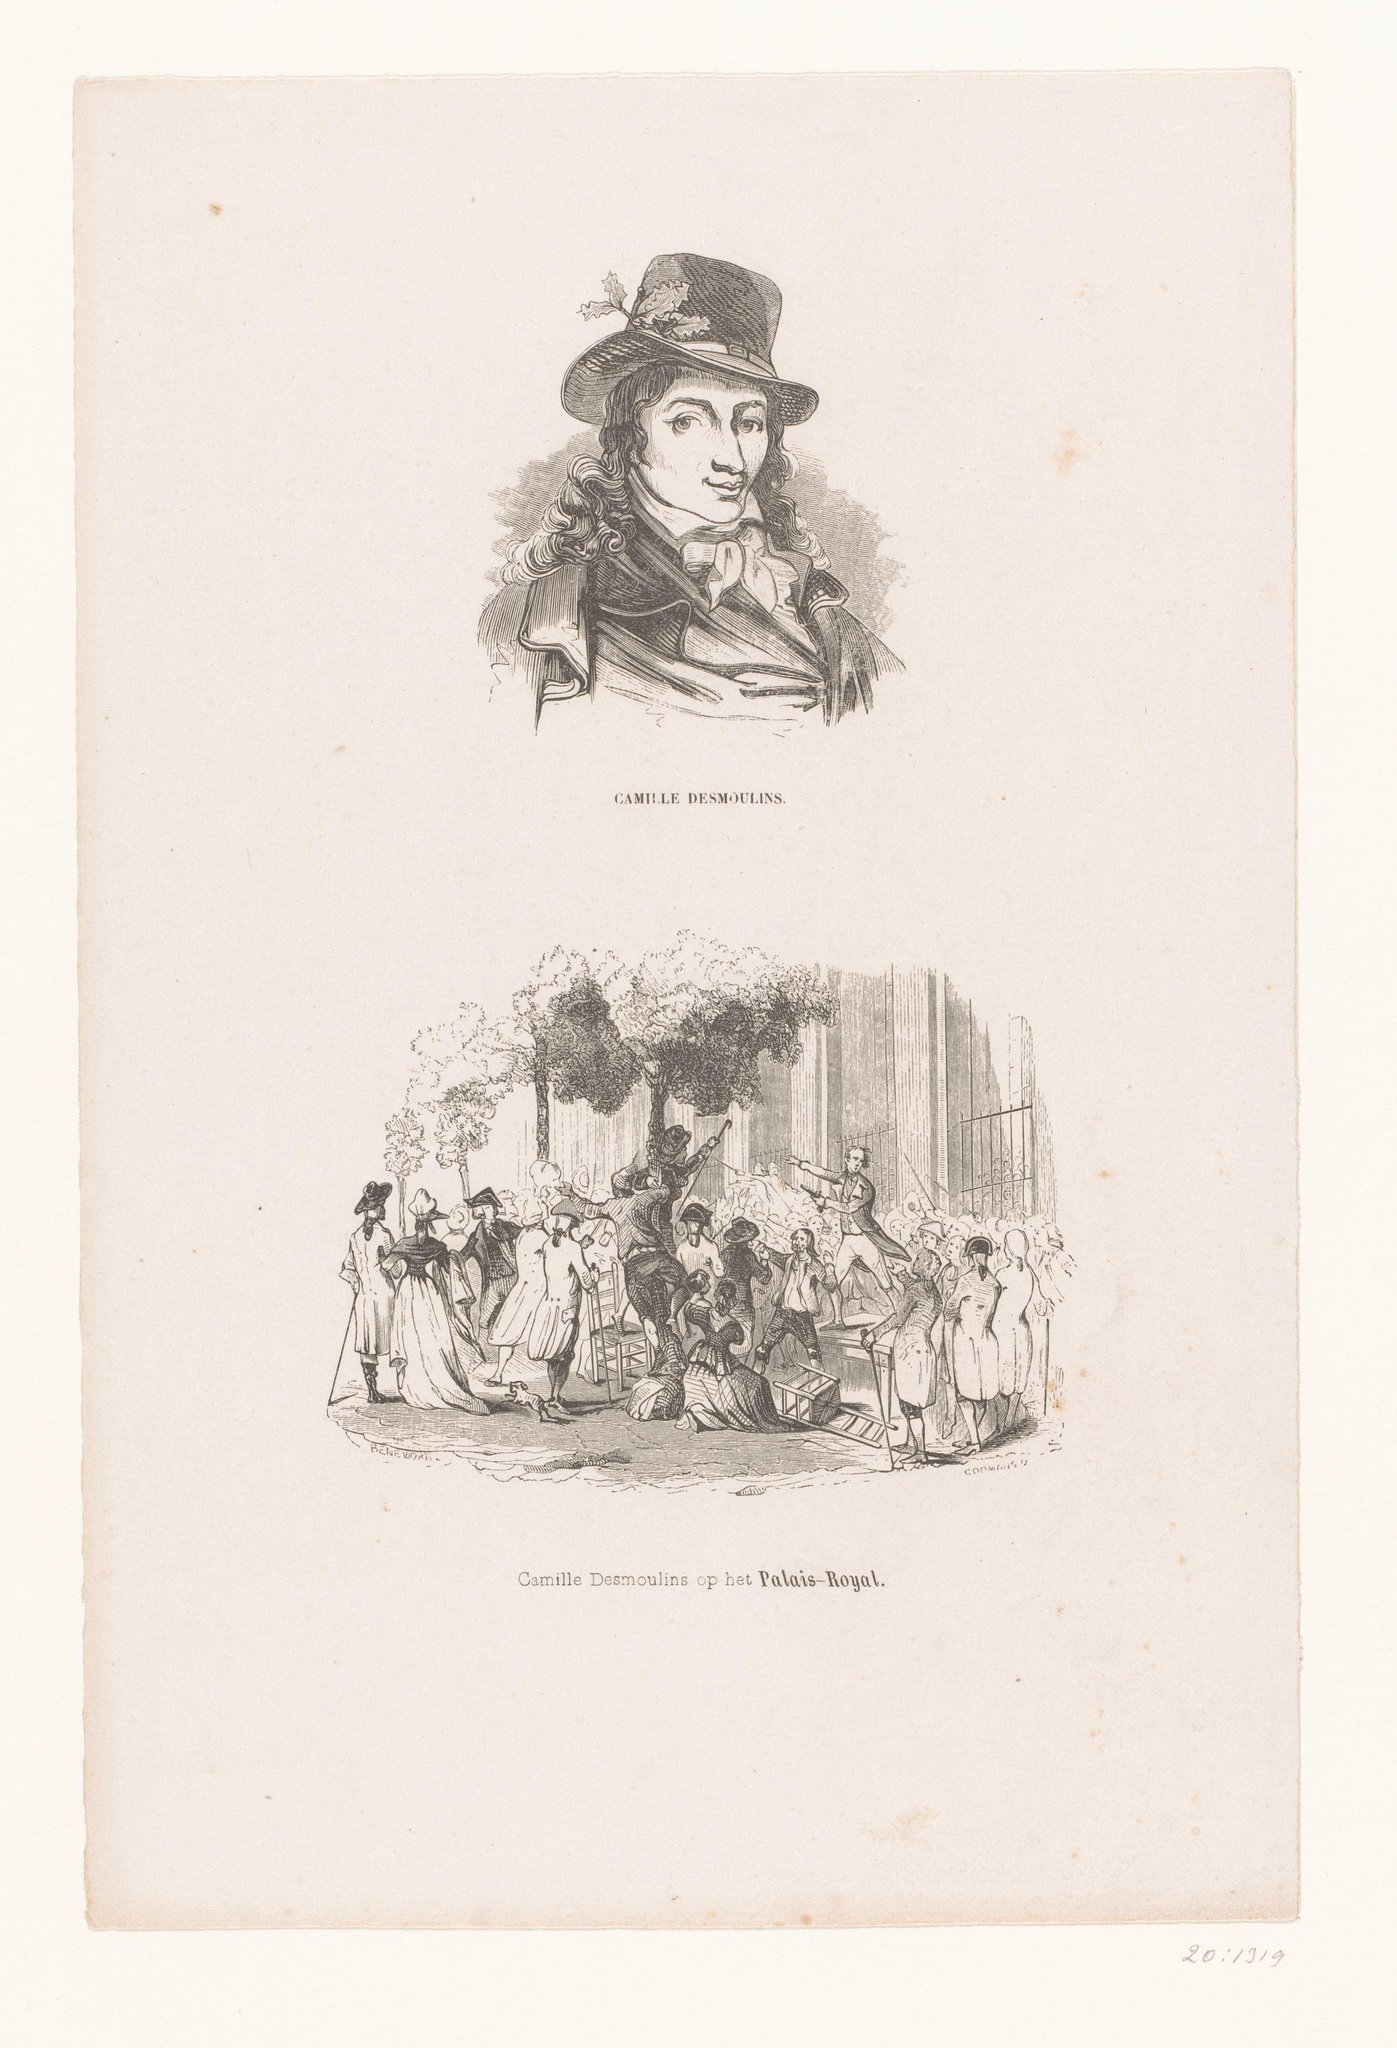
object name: print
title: Camille Desmoulins spreekt in de tuin van het Palais-Royal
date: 1826-1889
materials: paper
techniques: engraving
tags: paris, politician, oral revolutionary action, historical persons, palace, head-gear: top hat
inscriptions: collector's mark: Lugt 2228